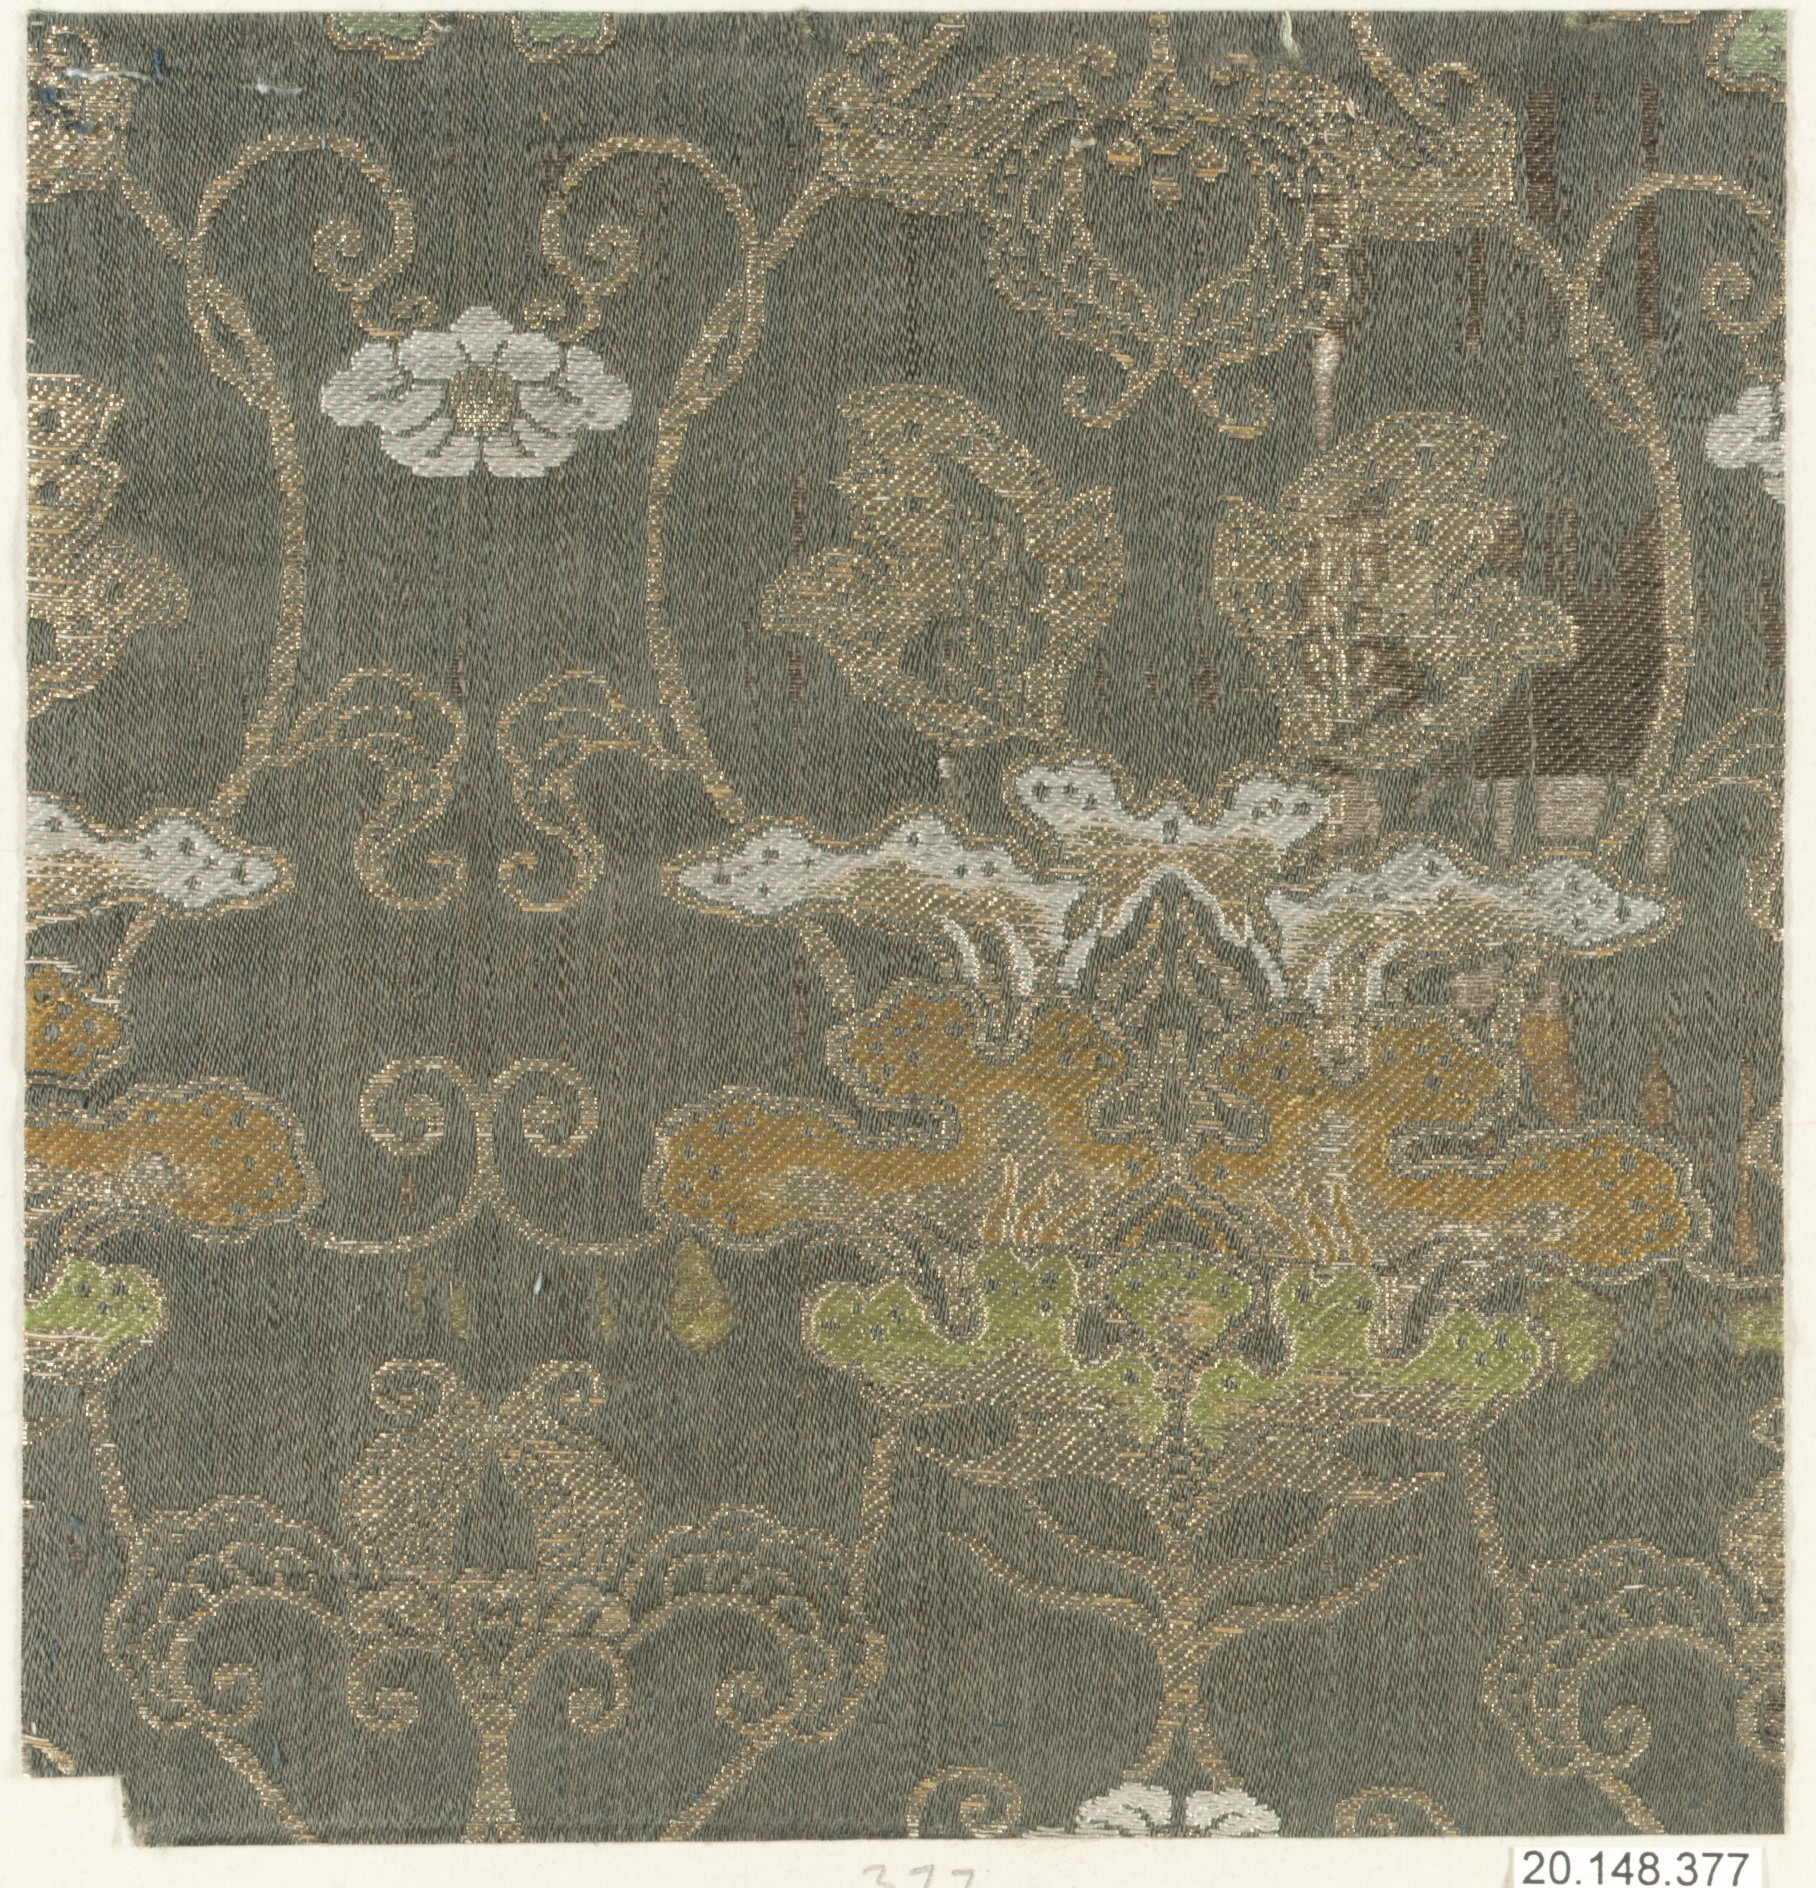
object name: piece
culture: japanese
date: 1701-1800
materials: silk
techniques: compound weave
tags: flowers,leaves